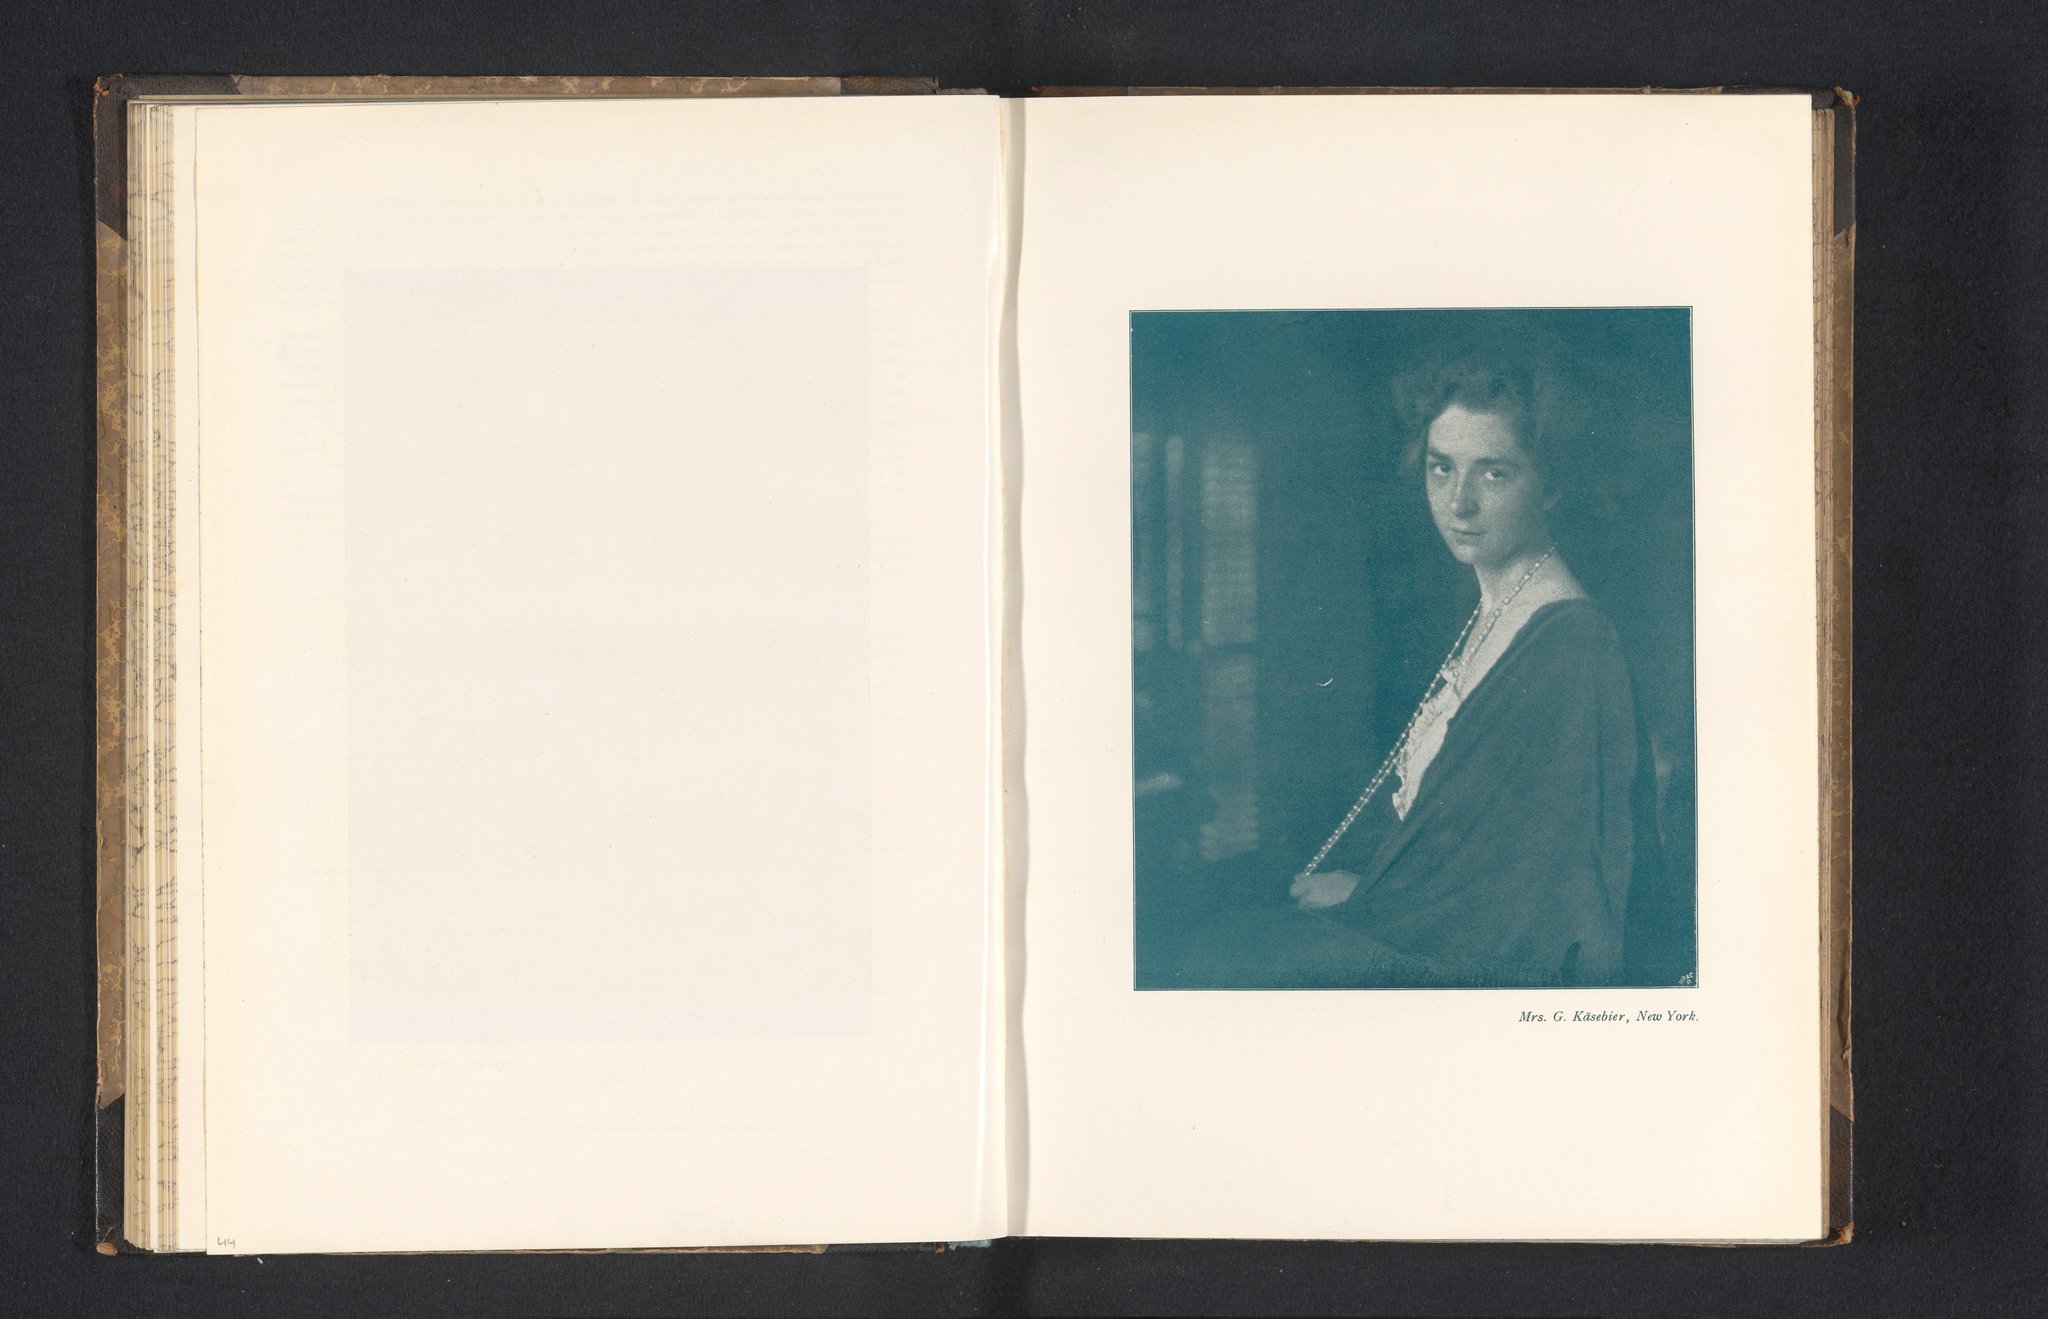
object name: photomechanical print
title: Portret van een onbekende vrouw met lange parelketting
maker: gertrude käsebier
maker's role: fotograaf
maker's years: 1852-1934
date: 1898-1903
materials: paper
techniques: autotype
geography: berlin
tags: historical persons not known by name - bb - woman, pearl; pearl necklace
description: Prent op tweede ongenummerde pagina na pagina 80.